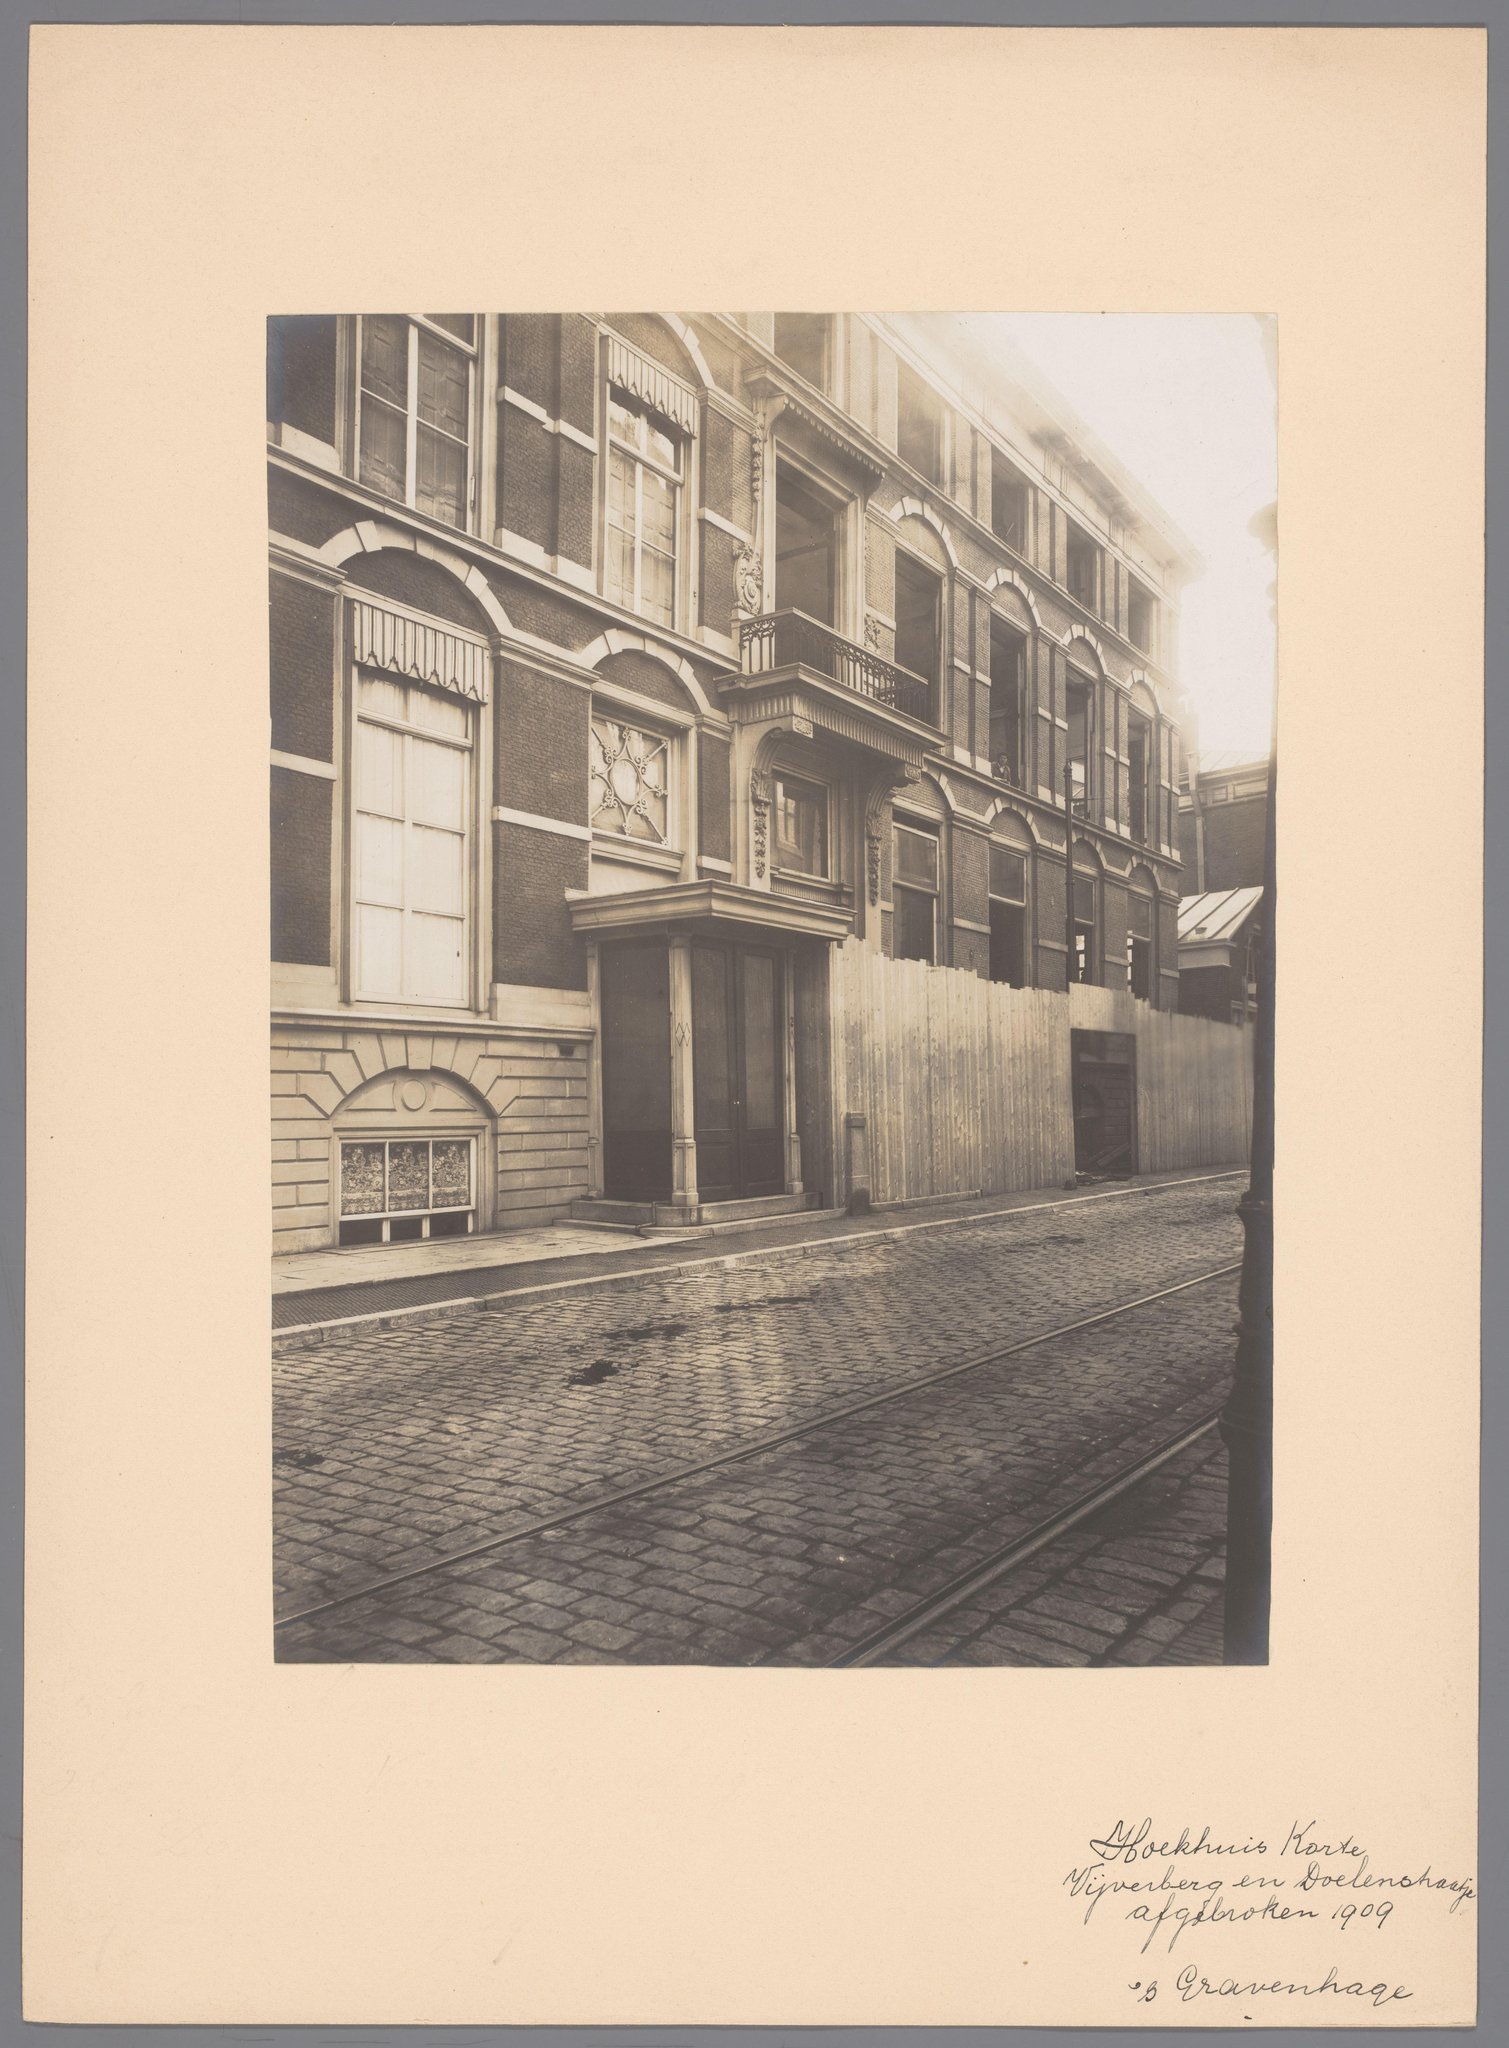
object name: photograph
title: Hoekhuis van de Korte Vijverberg en de Doelenstraat te Den Haag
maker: anoniem (monumentenzorg)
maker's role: fotograaf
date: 1904-1909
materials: cardboard, photographic support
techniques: gelatin silver print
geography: the hague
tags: façade (of house or building)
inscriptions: collector's mark: ‘R:MUS.’ Lugt 2228, annotation: ‘Hoekhuis Korte Vijverberg en Doelenstraatje/ afgebroken 1909/ 's Gravenhage’